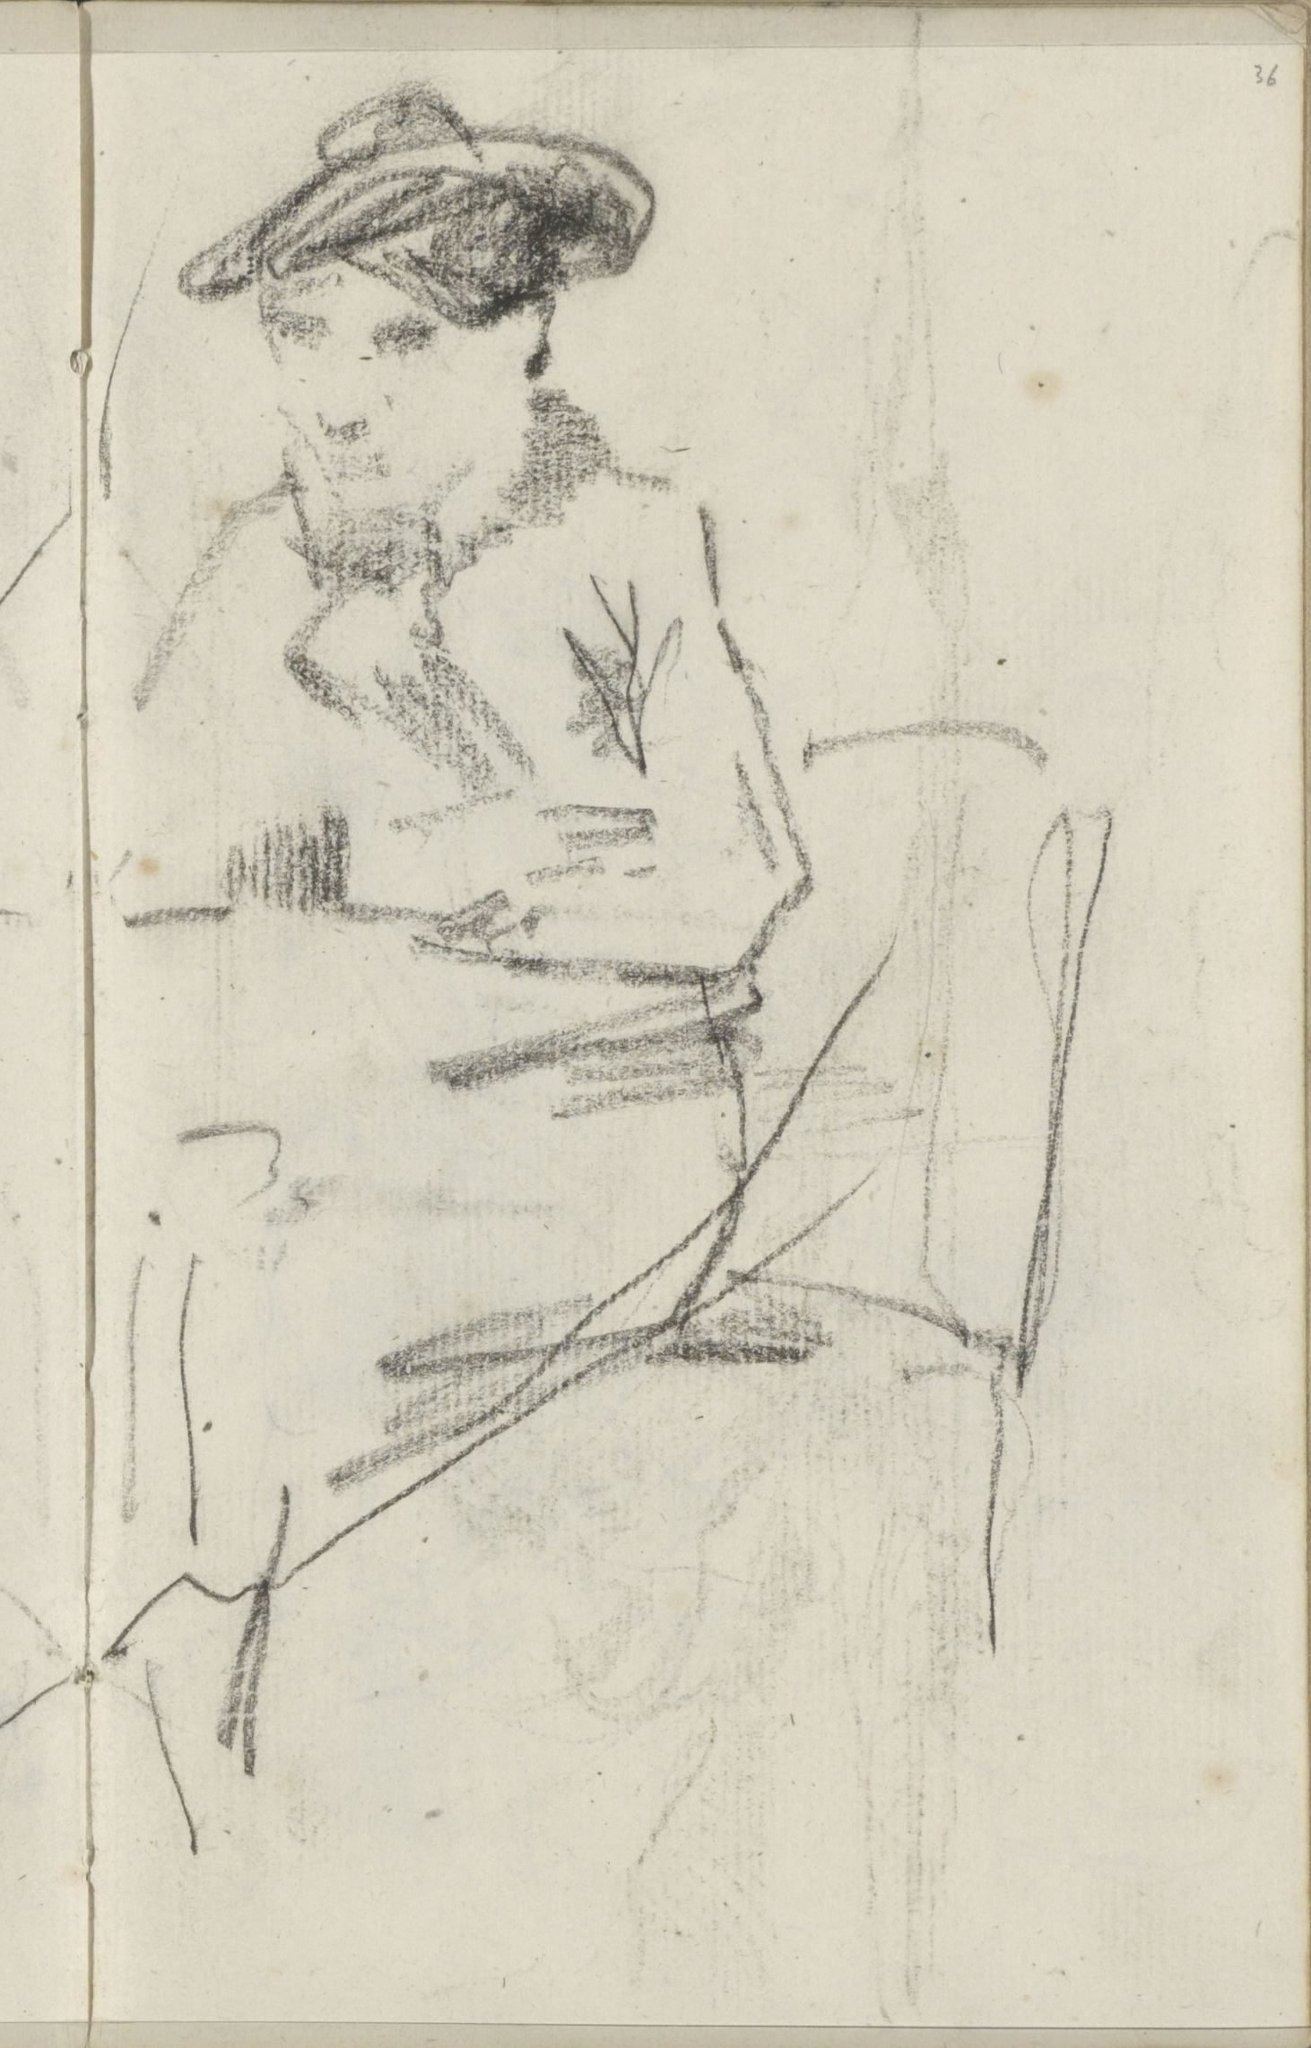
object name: sketchbook leaf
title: Zittende vrouw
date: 1880-1882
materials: chalk, paper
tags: sitting on an elevation - aa - female human figure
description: Pagina 36 uit een schetsboek met 31 bladen.